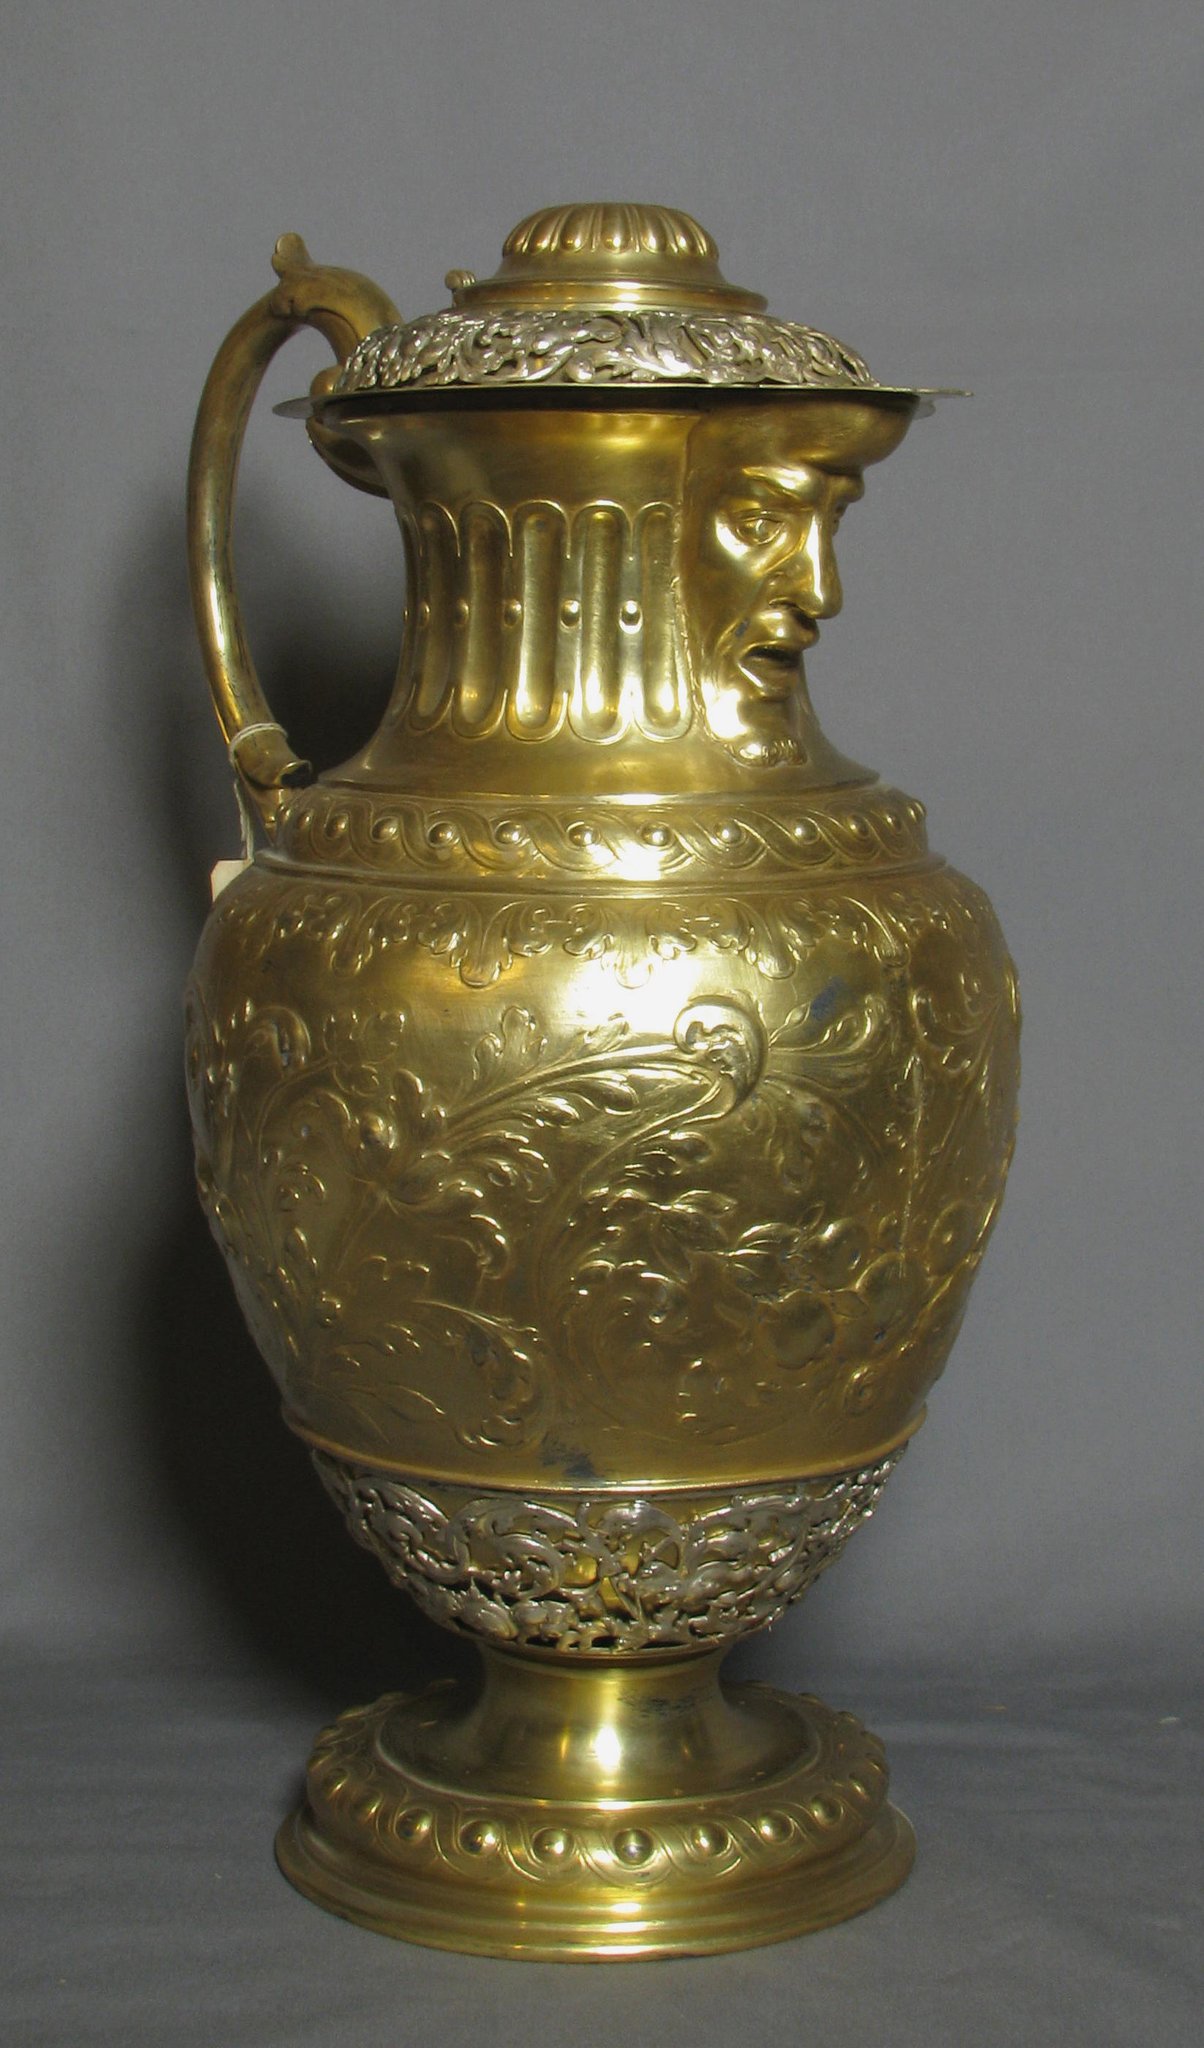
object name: ewer or jug with cover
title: Ewer or great jug with cover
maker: elkington & co.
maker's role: manufacturer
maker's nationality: british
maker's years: 1829-1963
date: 1801-1900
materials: metal, silver